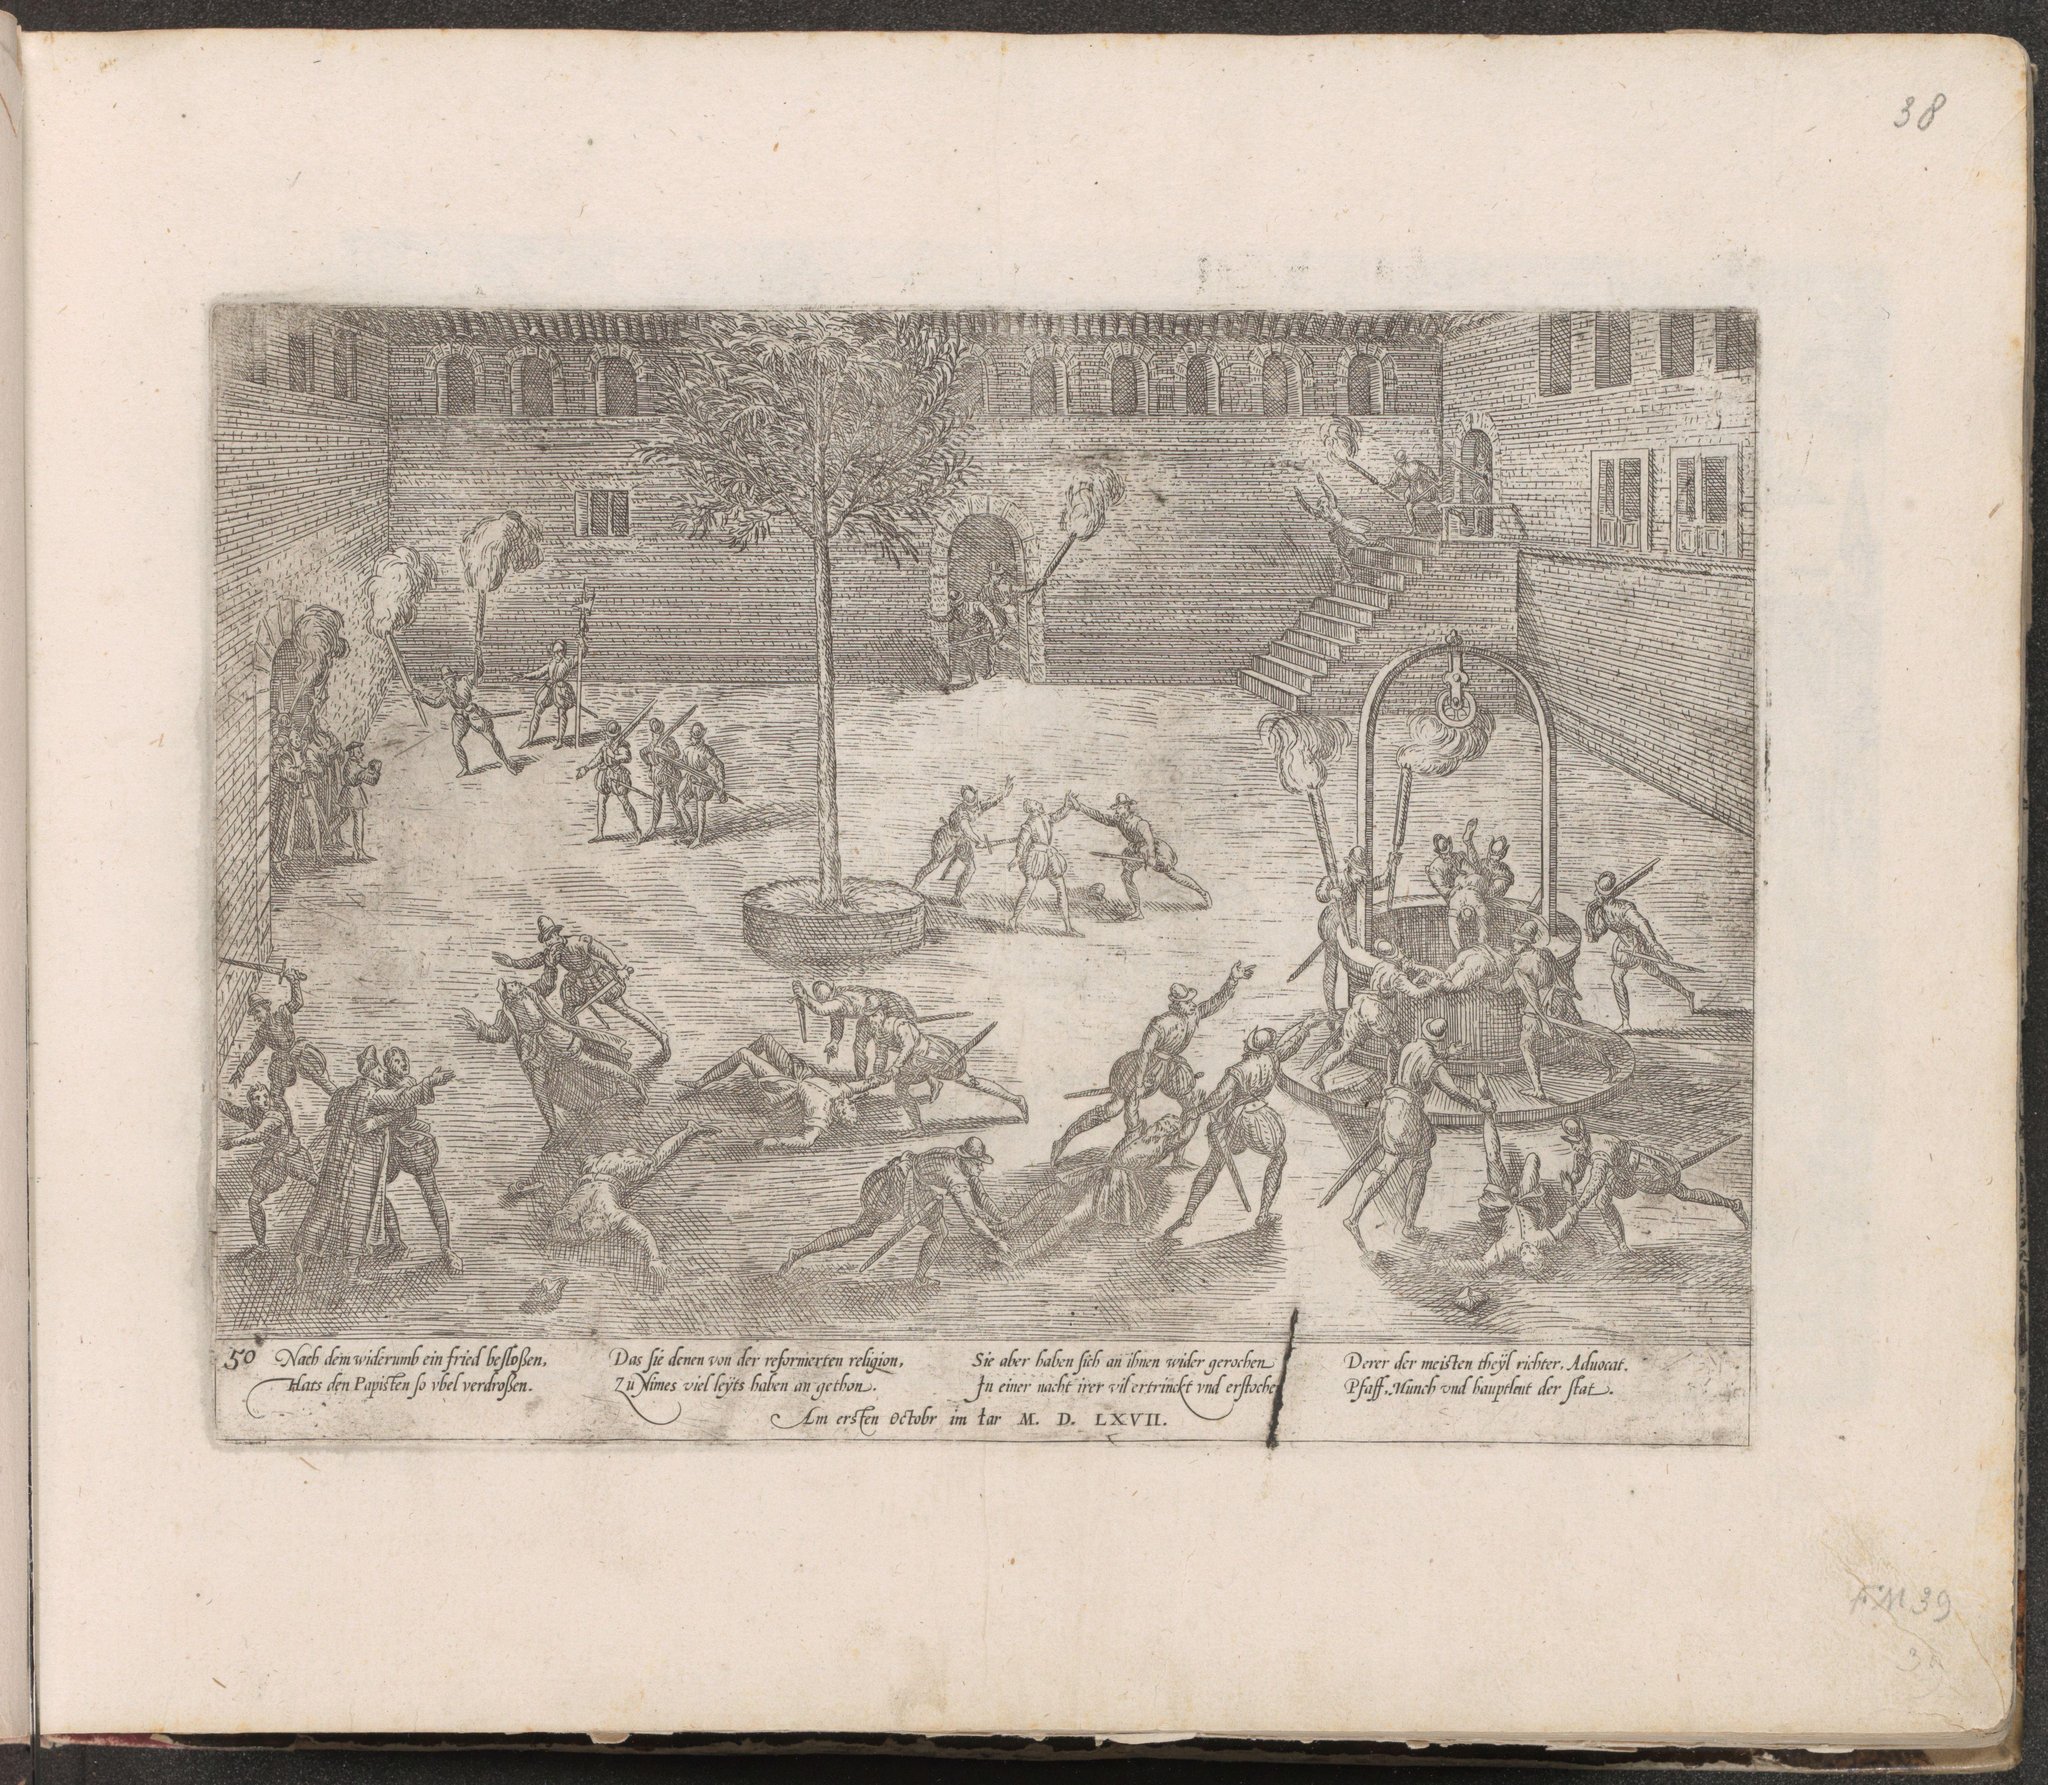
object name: album leaf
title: Serie 3: Franse Godsdienstoorlogen, 1559-1573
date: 1567-1571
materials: paper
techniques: etching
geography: cologne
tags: massacre ~ war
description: Overval te Nîmes door de hugenoten, 1 oktober 1567. Moordpartij op de binnenplaats van een klooster, lijken worden in de waterput gegooid. Met onderschrift van 8 regels in het Duits. Linksonder genummerd: 50. De prent maakt deel uit van een album.